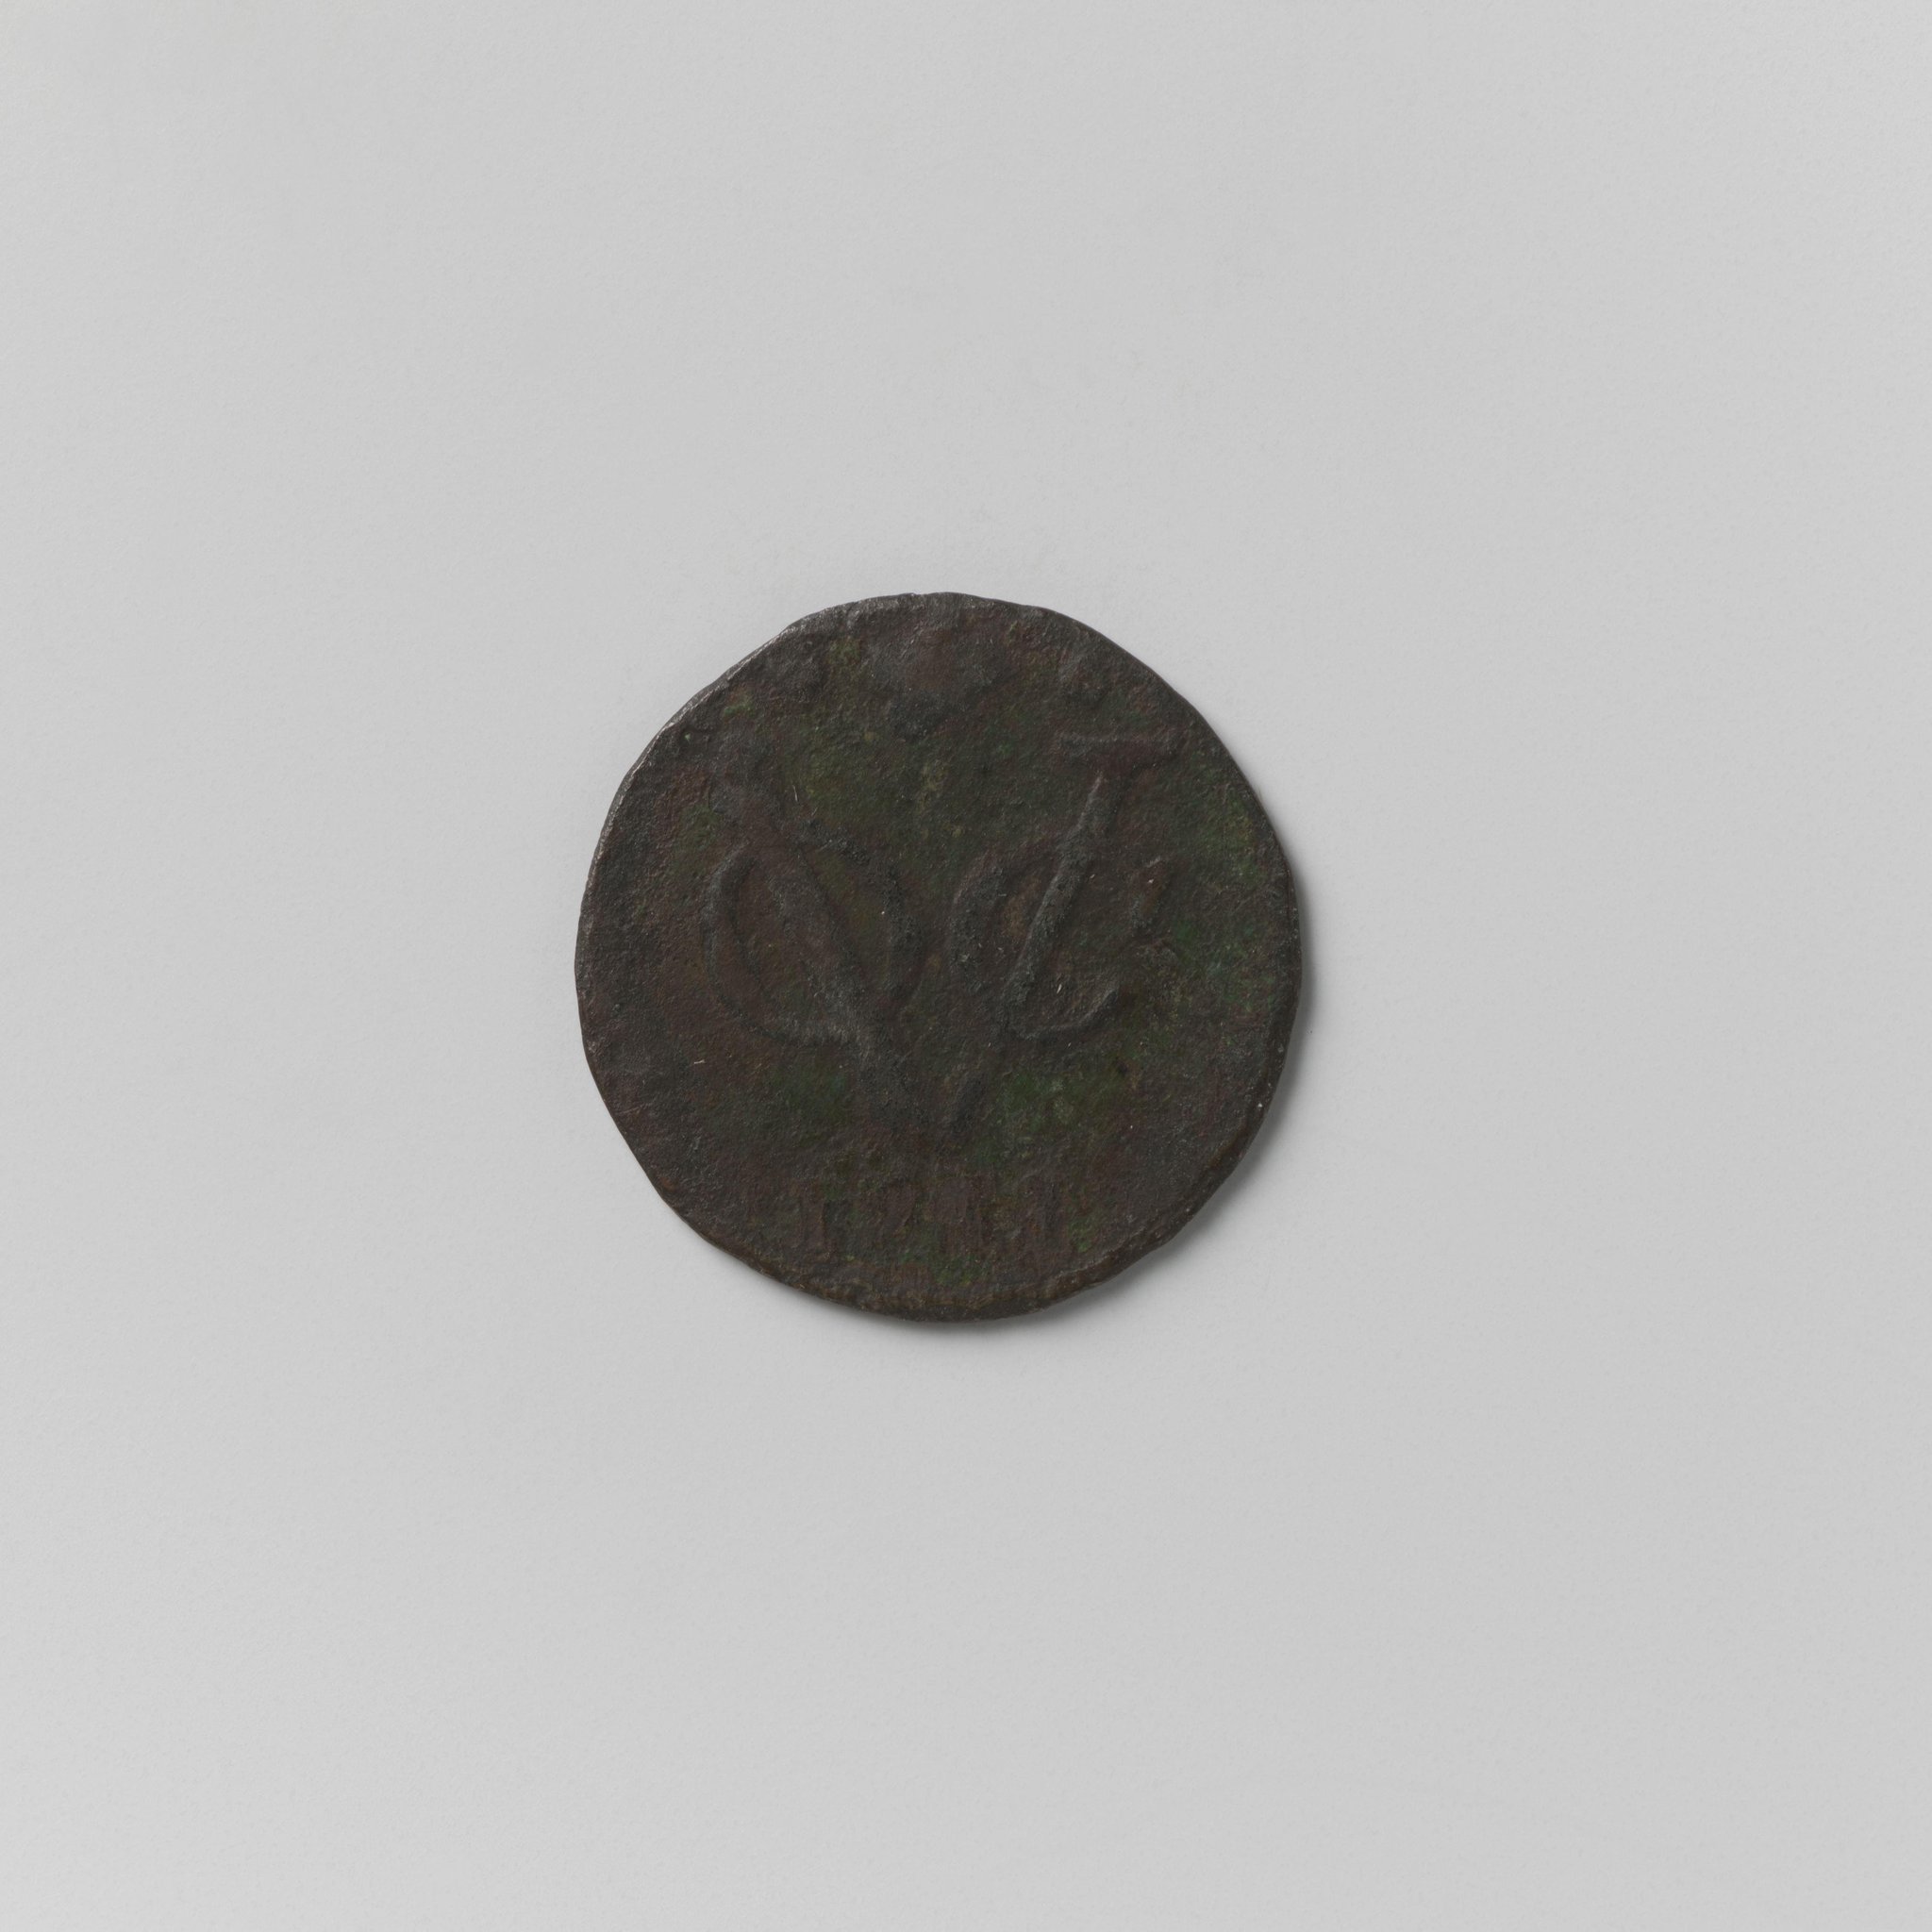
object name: coin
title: Valse ½ duit van de VOC uit Holland, 1757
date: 1757-1799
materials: copper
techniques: striking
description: Valse koperen munt. Voorzijde: tussen wapenspreuk gekroond wapenschild van Holland. Keerzijde: monogram van de VOC, waarboven muntteken en waaronder jaartal. Vervalsing. Jaartal bestaat niet.